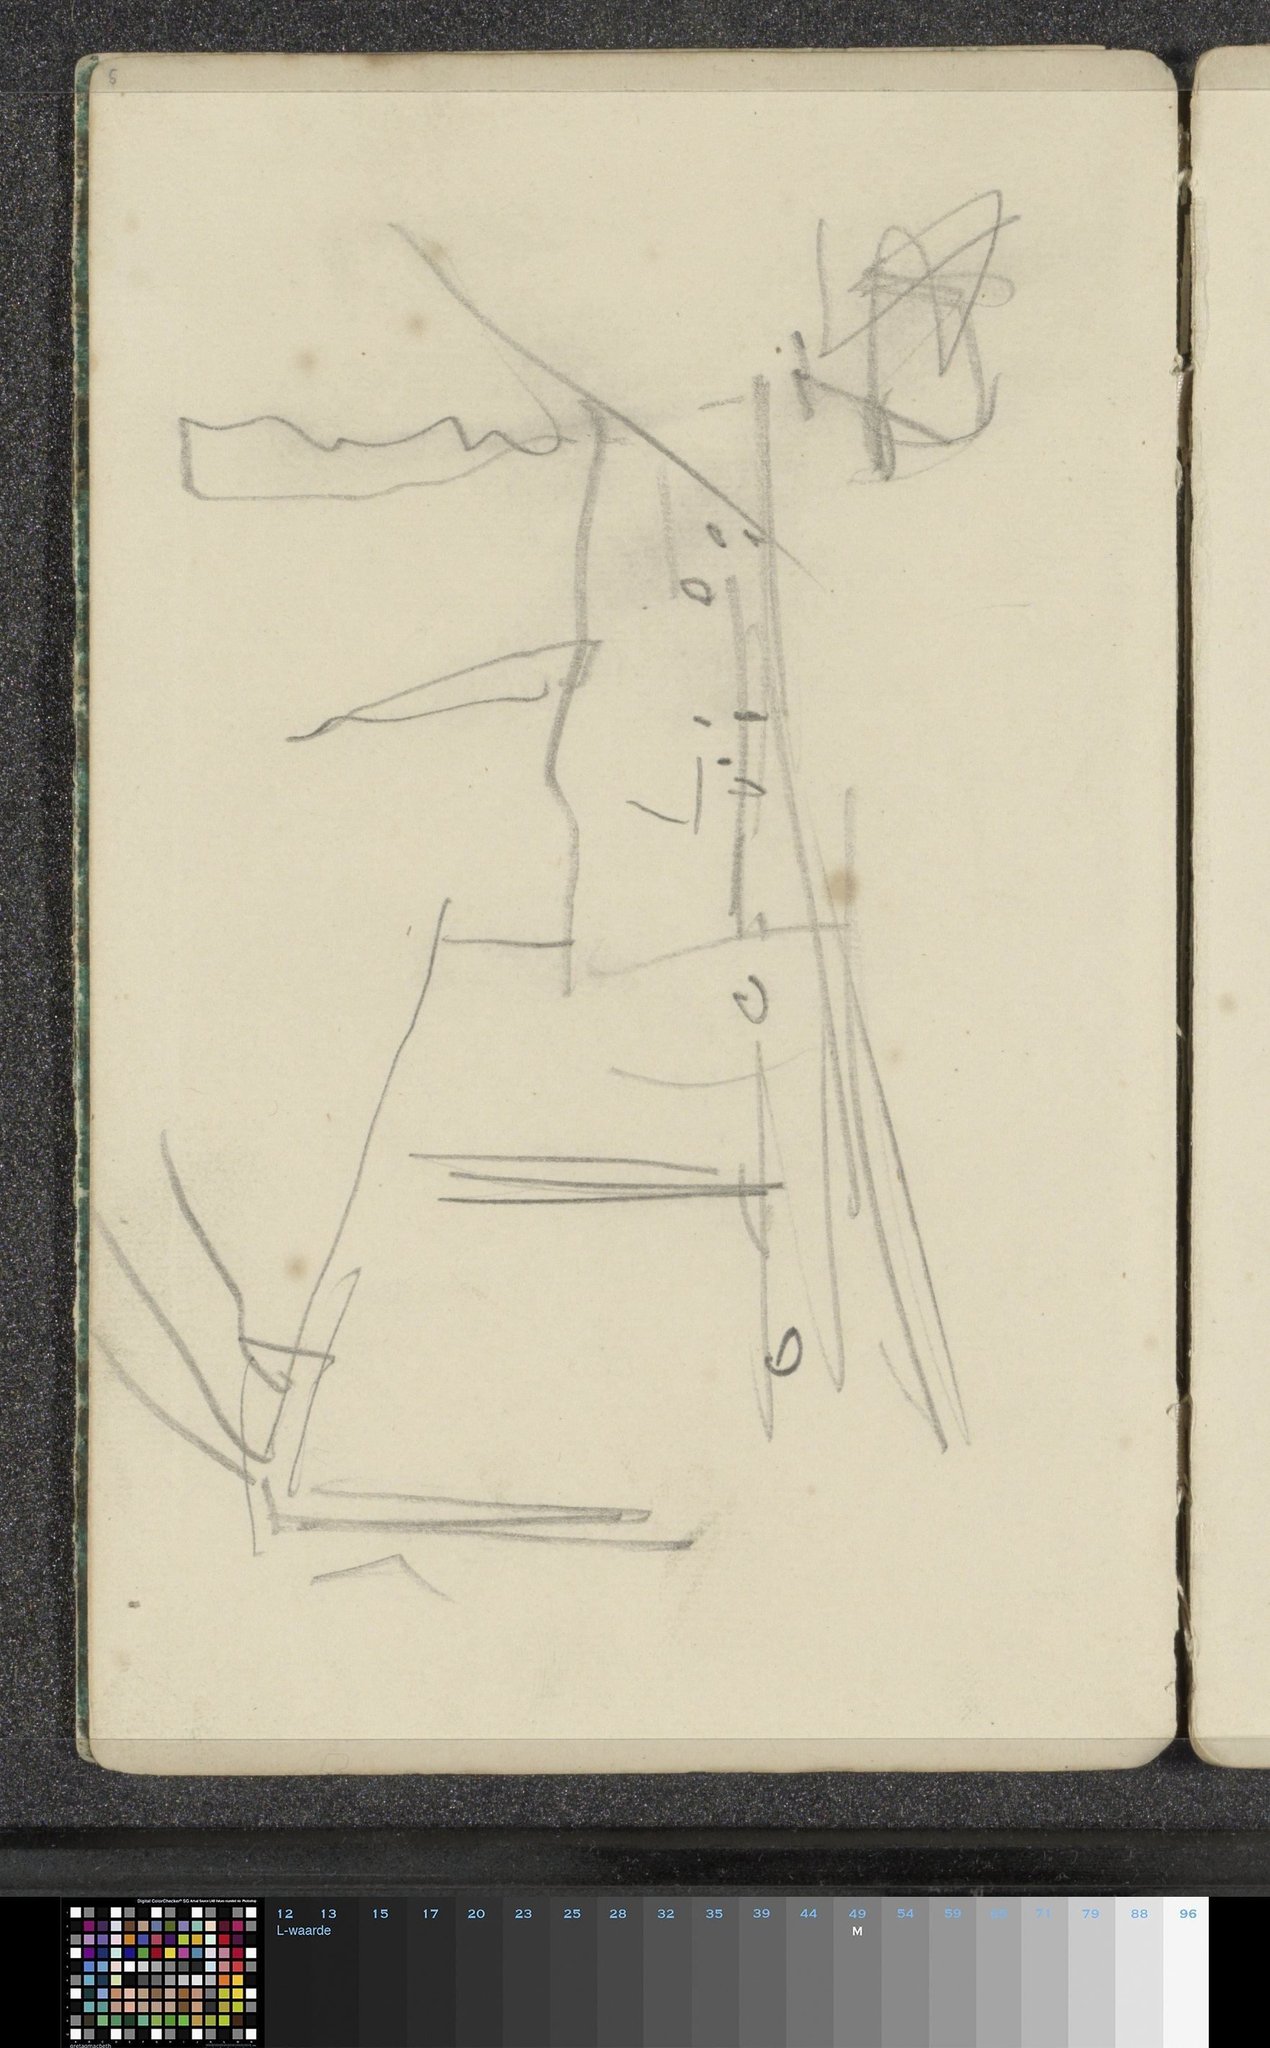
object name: sketchbook leaf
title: Studie, mogelijk een stadsgezicht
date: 1884-1886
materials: paper, pencil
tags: city-view, and landscape with man-made constructions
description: Pagina 5 uit een schetsboek met 16 bladen.